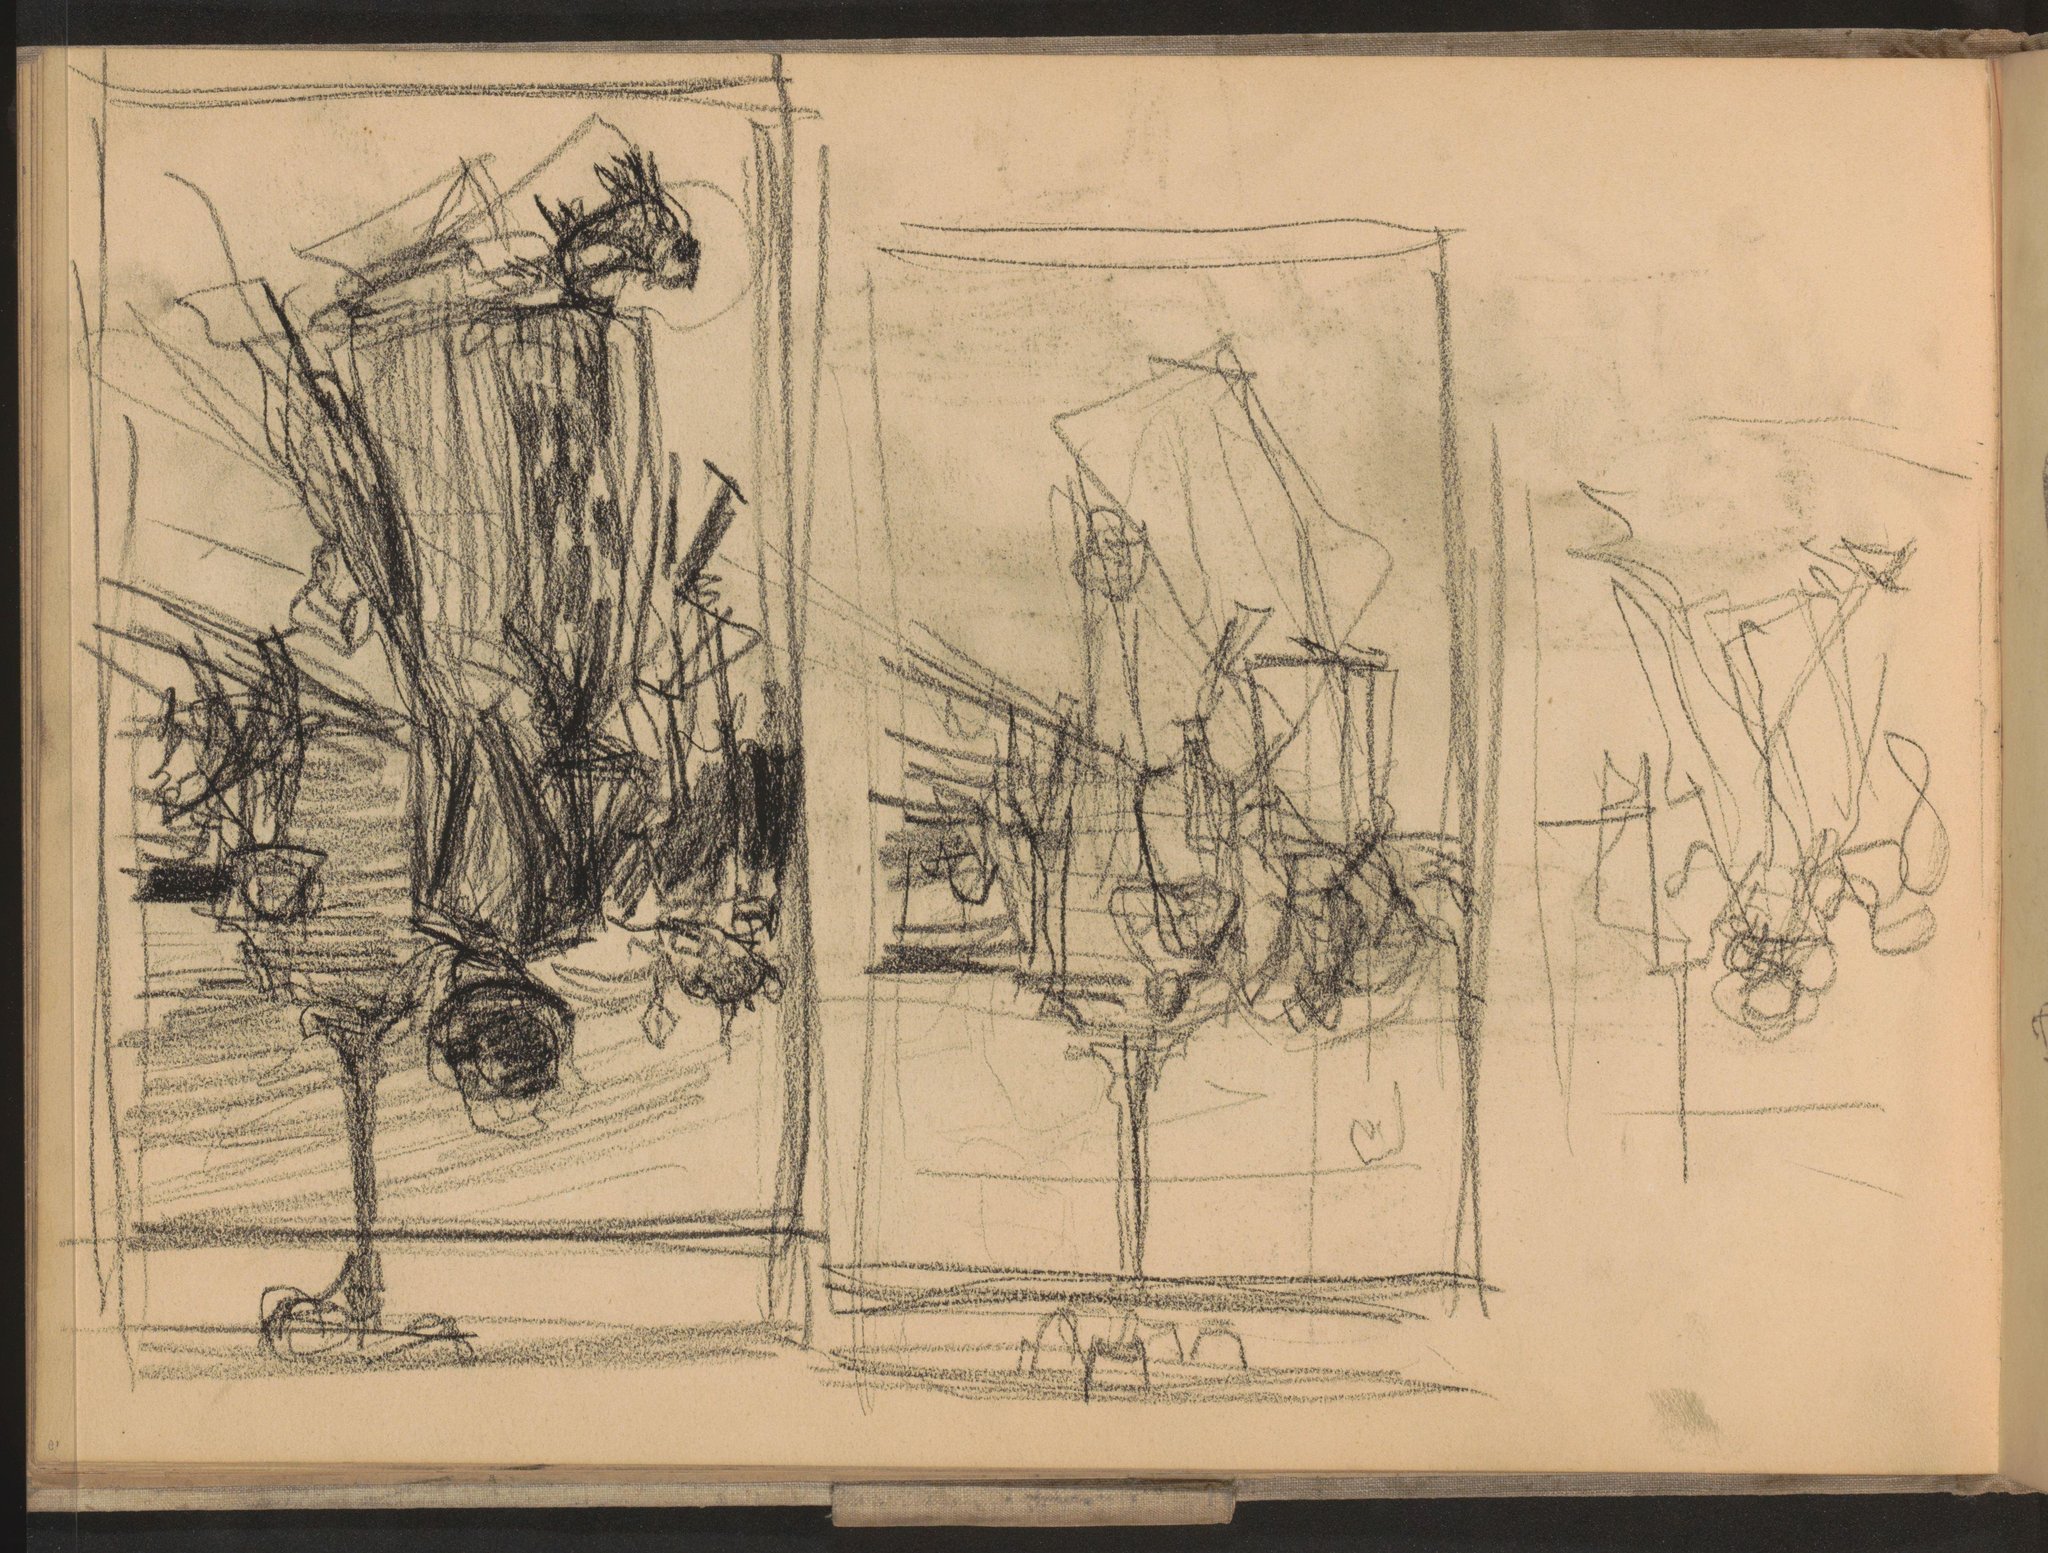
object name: sketchbook leaf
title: Figuren in een straat met een monument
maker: marius bauer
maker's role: draughtsman, print maker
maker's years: 1867-1932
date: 1887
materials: chalk, paper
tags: adult woman, monument, statue, walking, street lighting, dog, street (+ city(-scape) with figures, staffage)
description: Eén van de studies toont op de voorgrond een vrouw met een hond. Pagina 18 uit een schetsboek met 19 bladen.